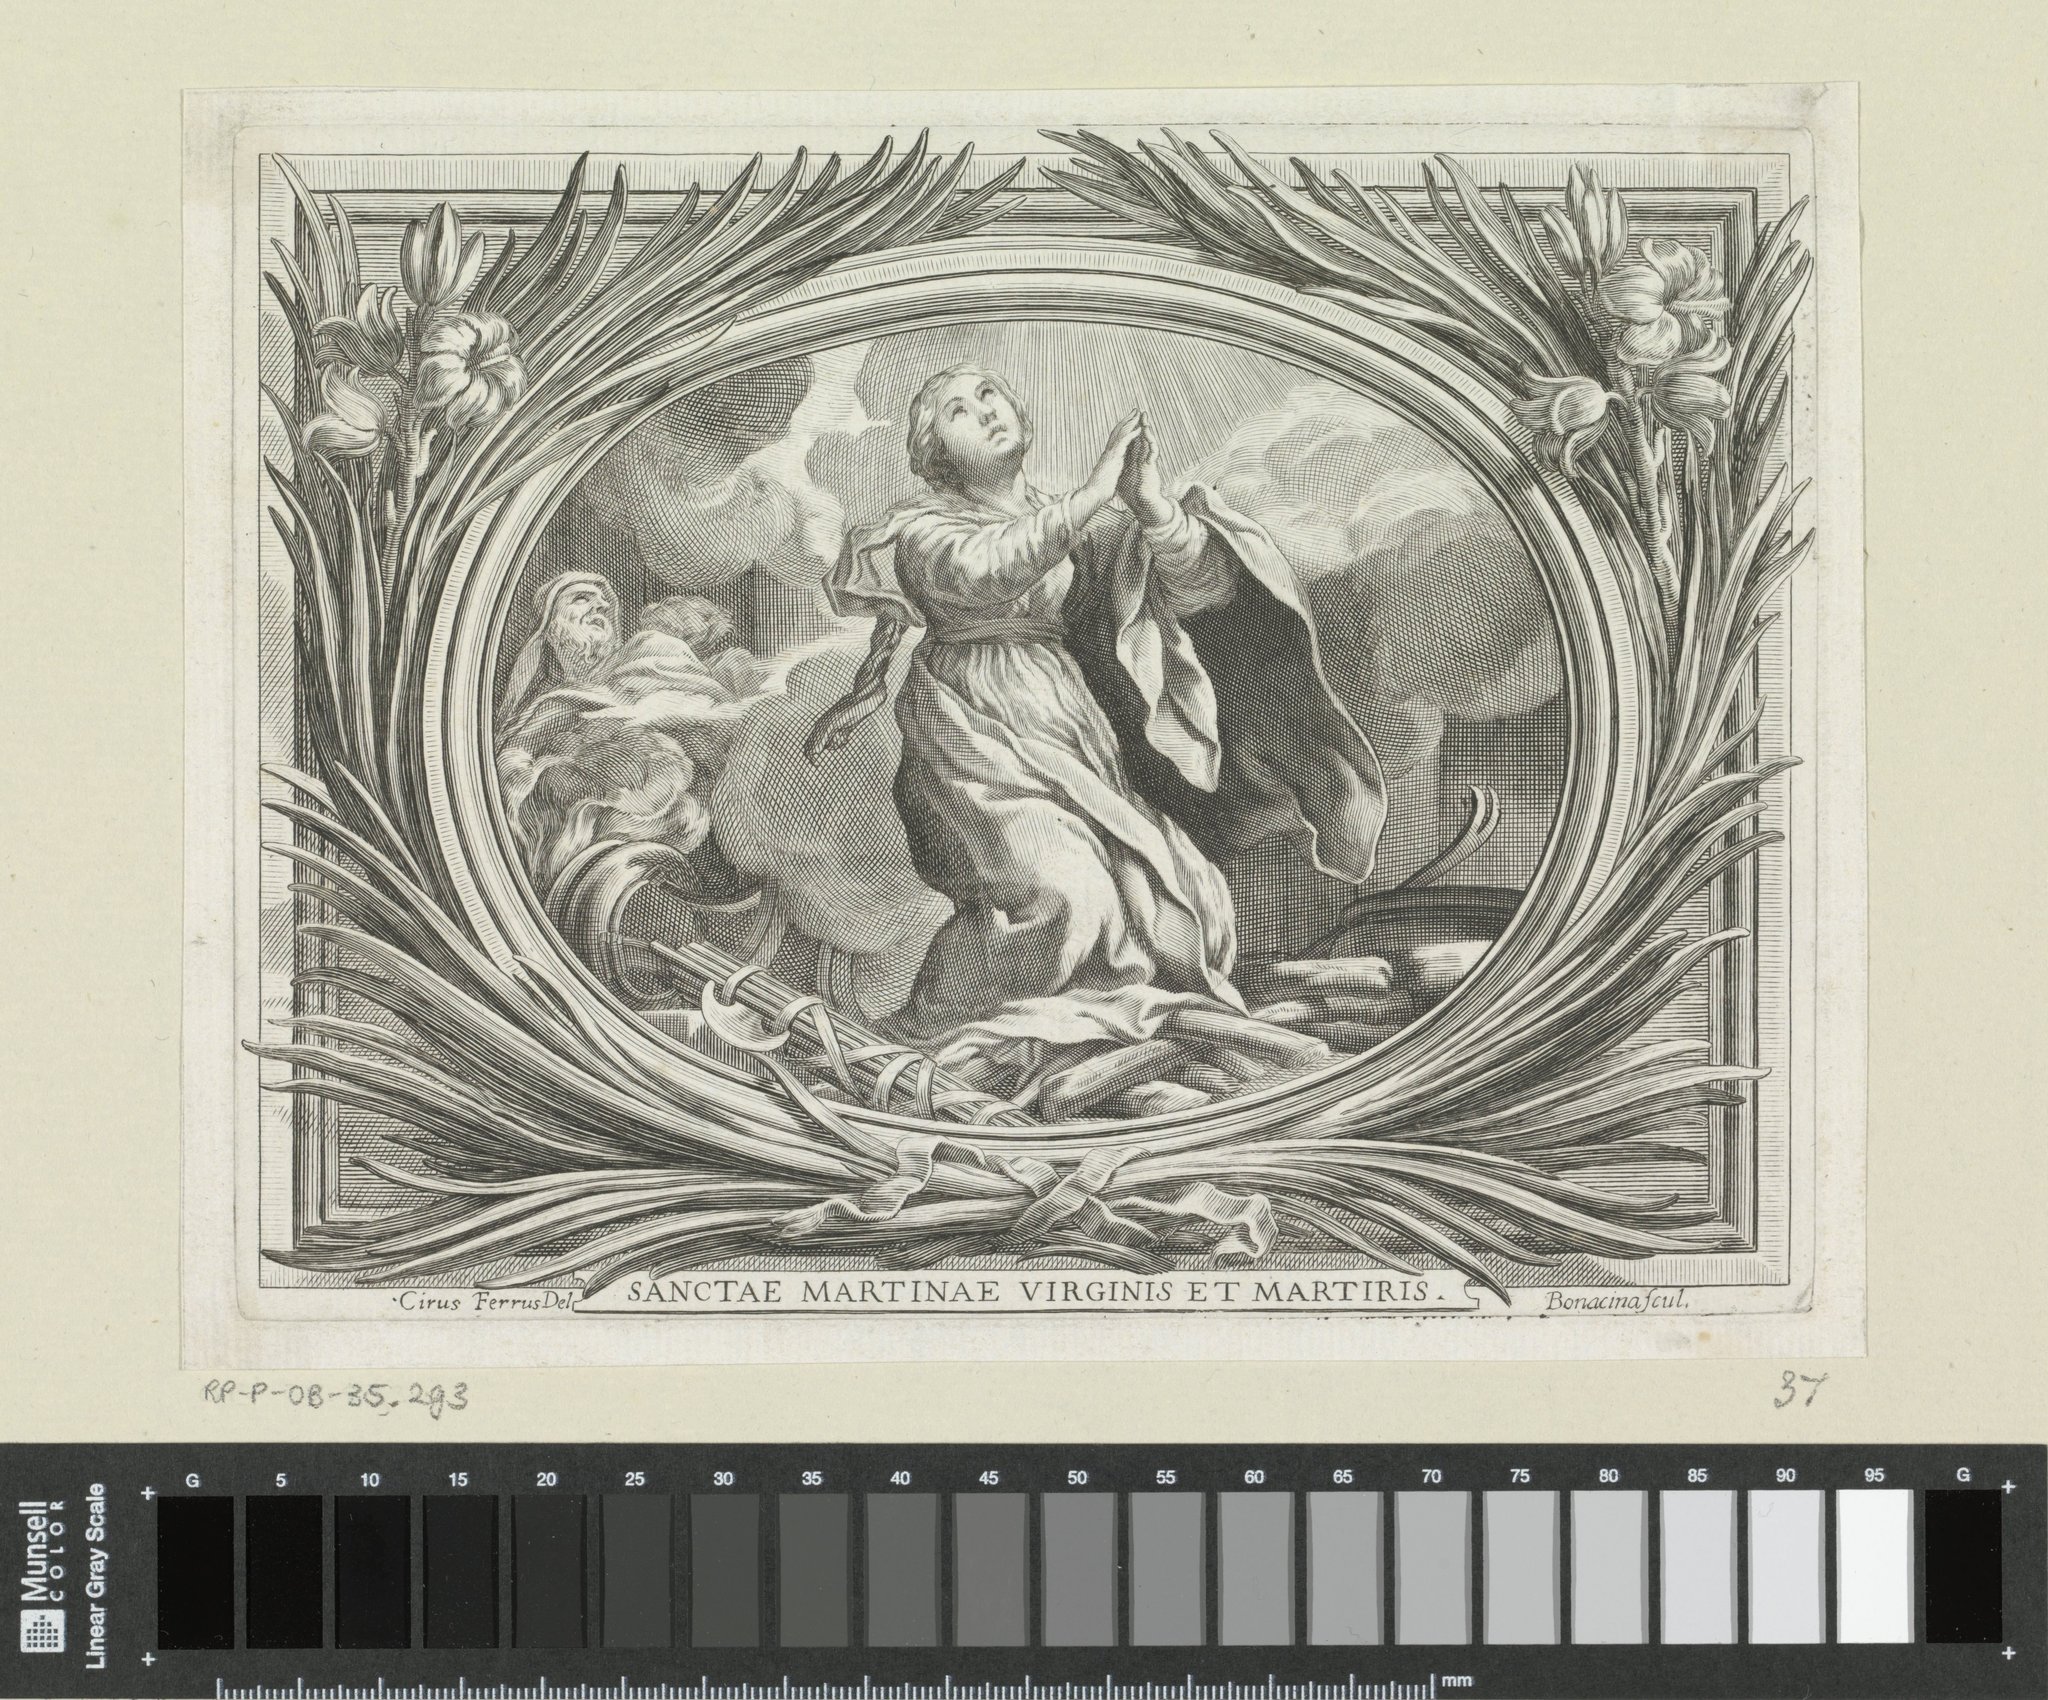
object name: print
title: Sanctae Martinae virginis et martiris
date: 1625-1669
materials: paper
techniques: engraving, etching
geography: italy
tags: martyr(s) (often with palm-branches) - qq - female martyr, female saints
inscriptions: collector's mark: Lugt 240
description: De heilige Martina zit geknield in gebed op een brandstapel. De voorstelling is gevat in een ovale lijst met palmtakken.